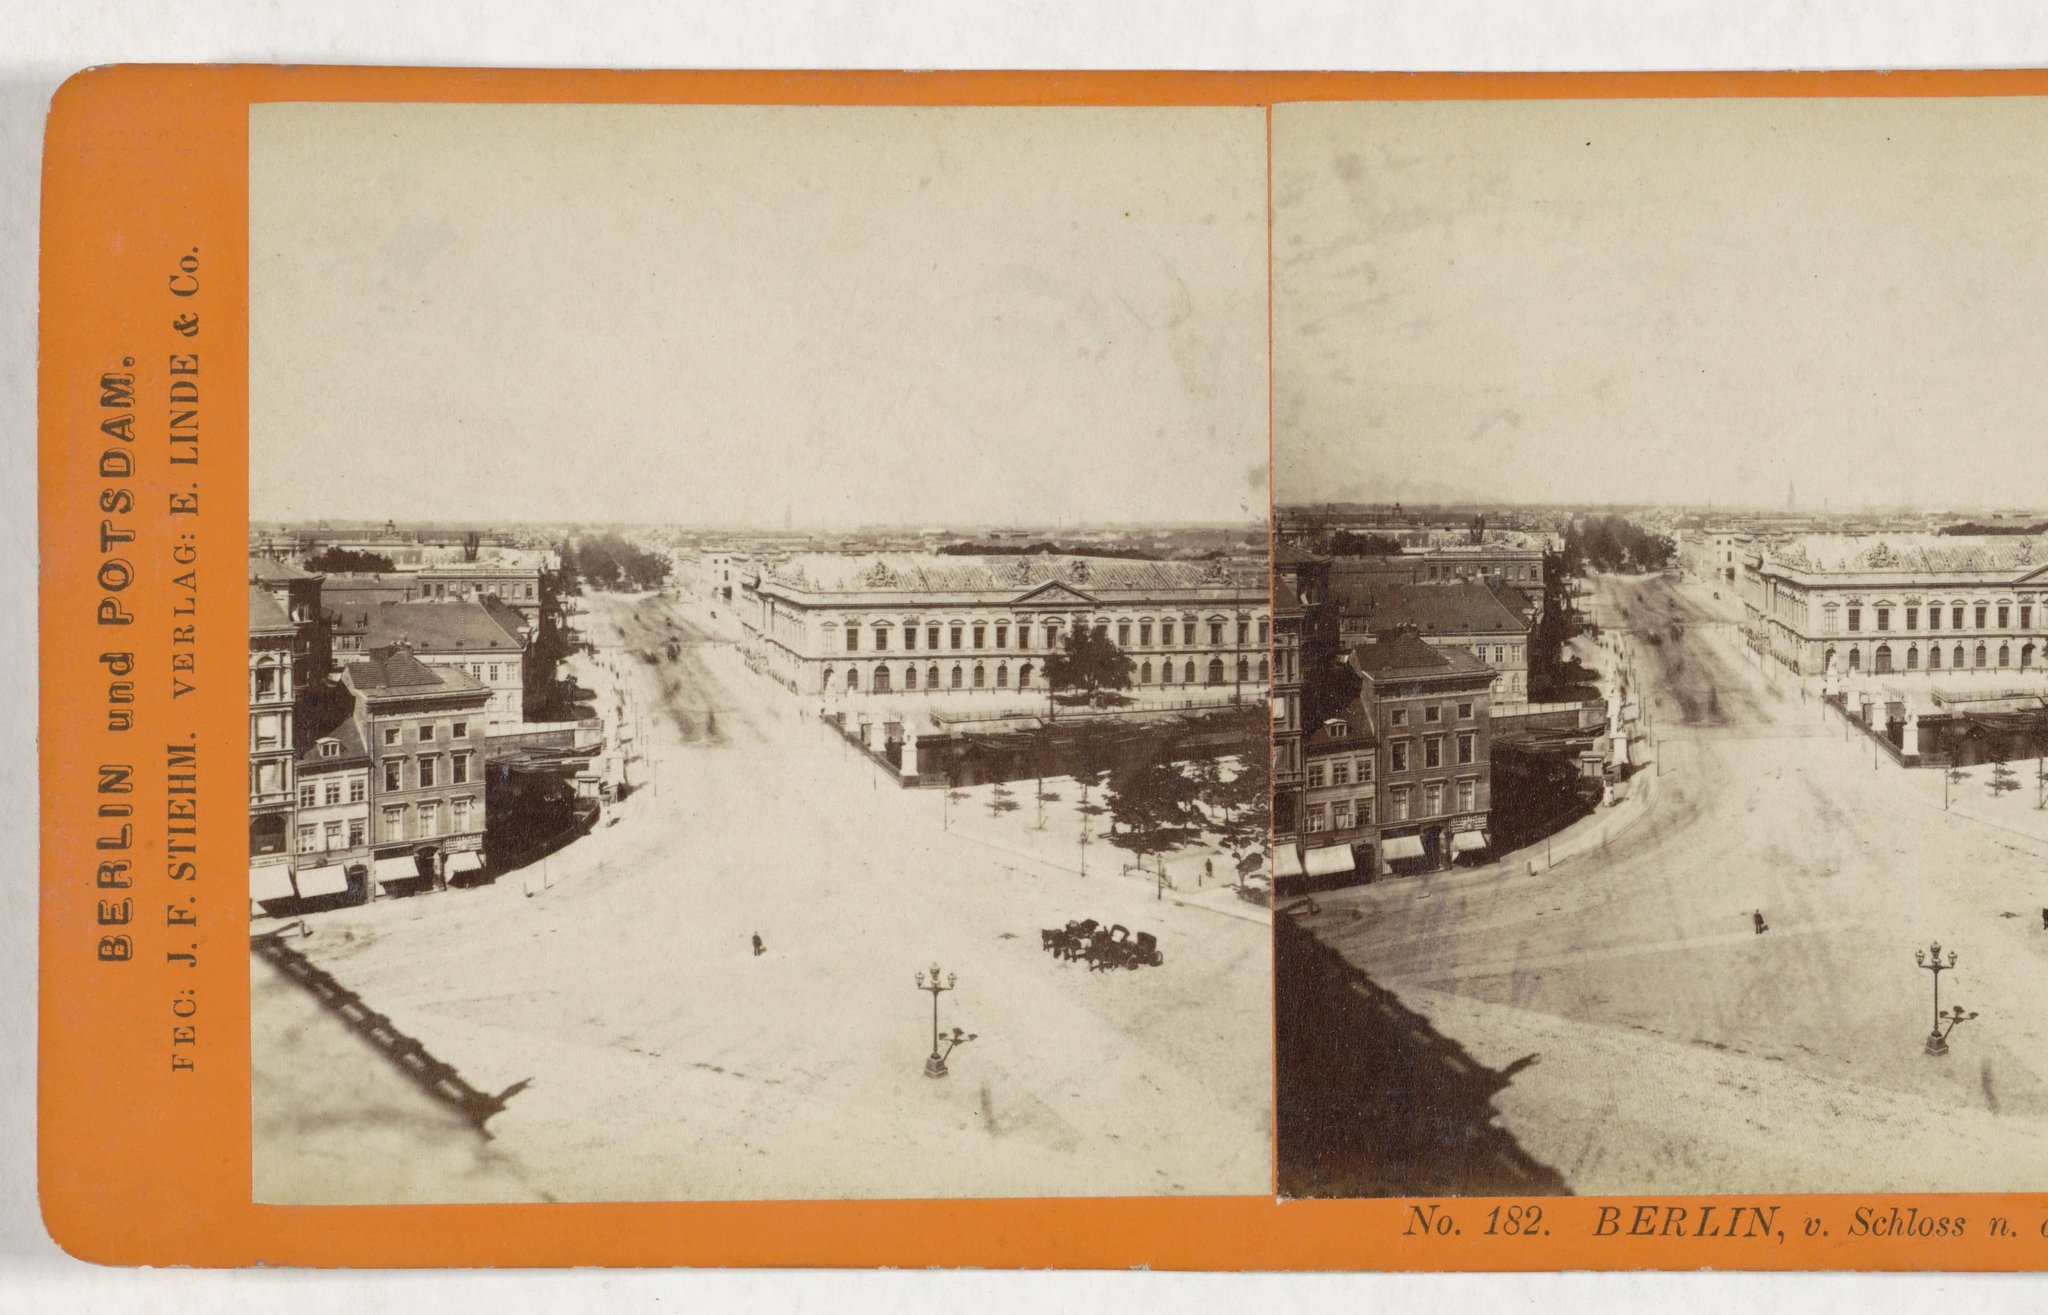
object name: stereograph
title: Ansichten von Deutschland / Berlin und Potsdam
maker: johann friedrich stiehm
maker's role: fotograaf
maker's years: 1826-1902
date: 1868-1870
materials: cardboard, paper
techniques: albumen print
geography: berlin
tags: prospect of city, town panorama, silhouette of city, berlin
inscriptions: number: ‘No. 182.’